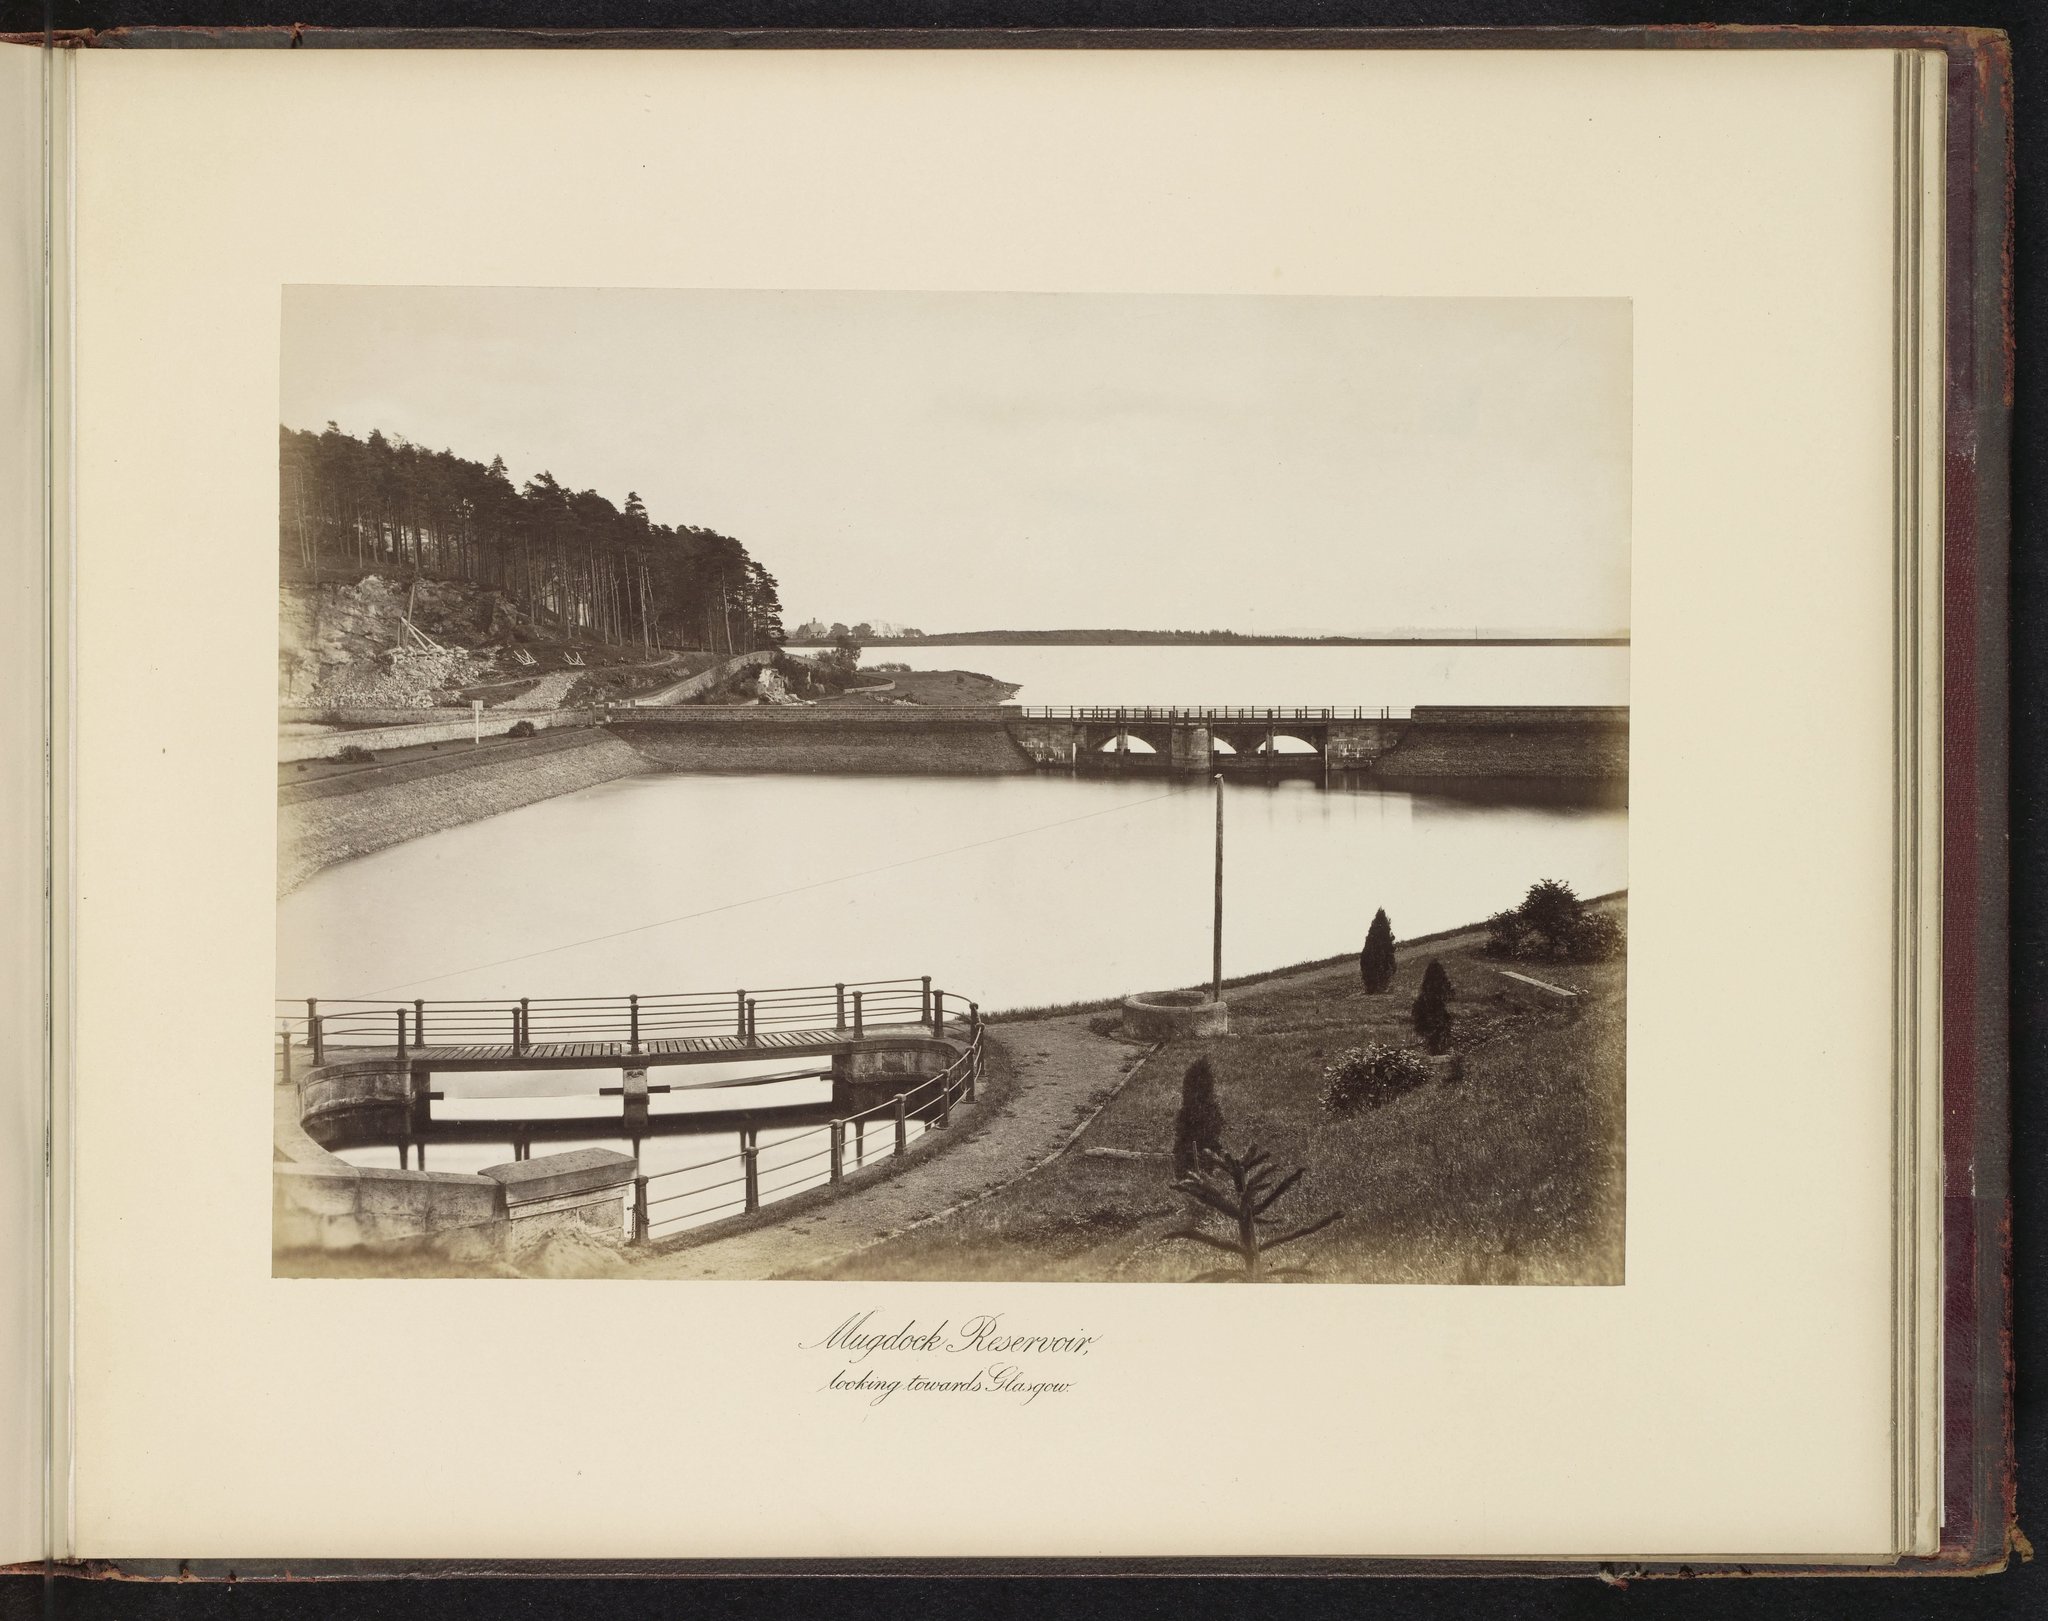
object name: page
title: Mugdock Reservoir, looking towards Glasgow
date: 1879-1889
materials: photographic support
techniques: albumen print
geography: scotland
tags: sink, basin